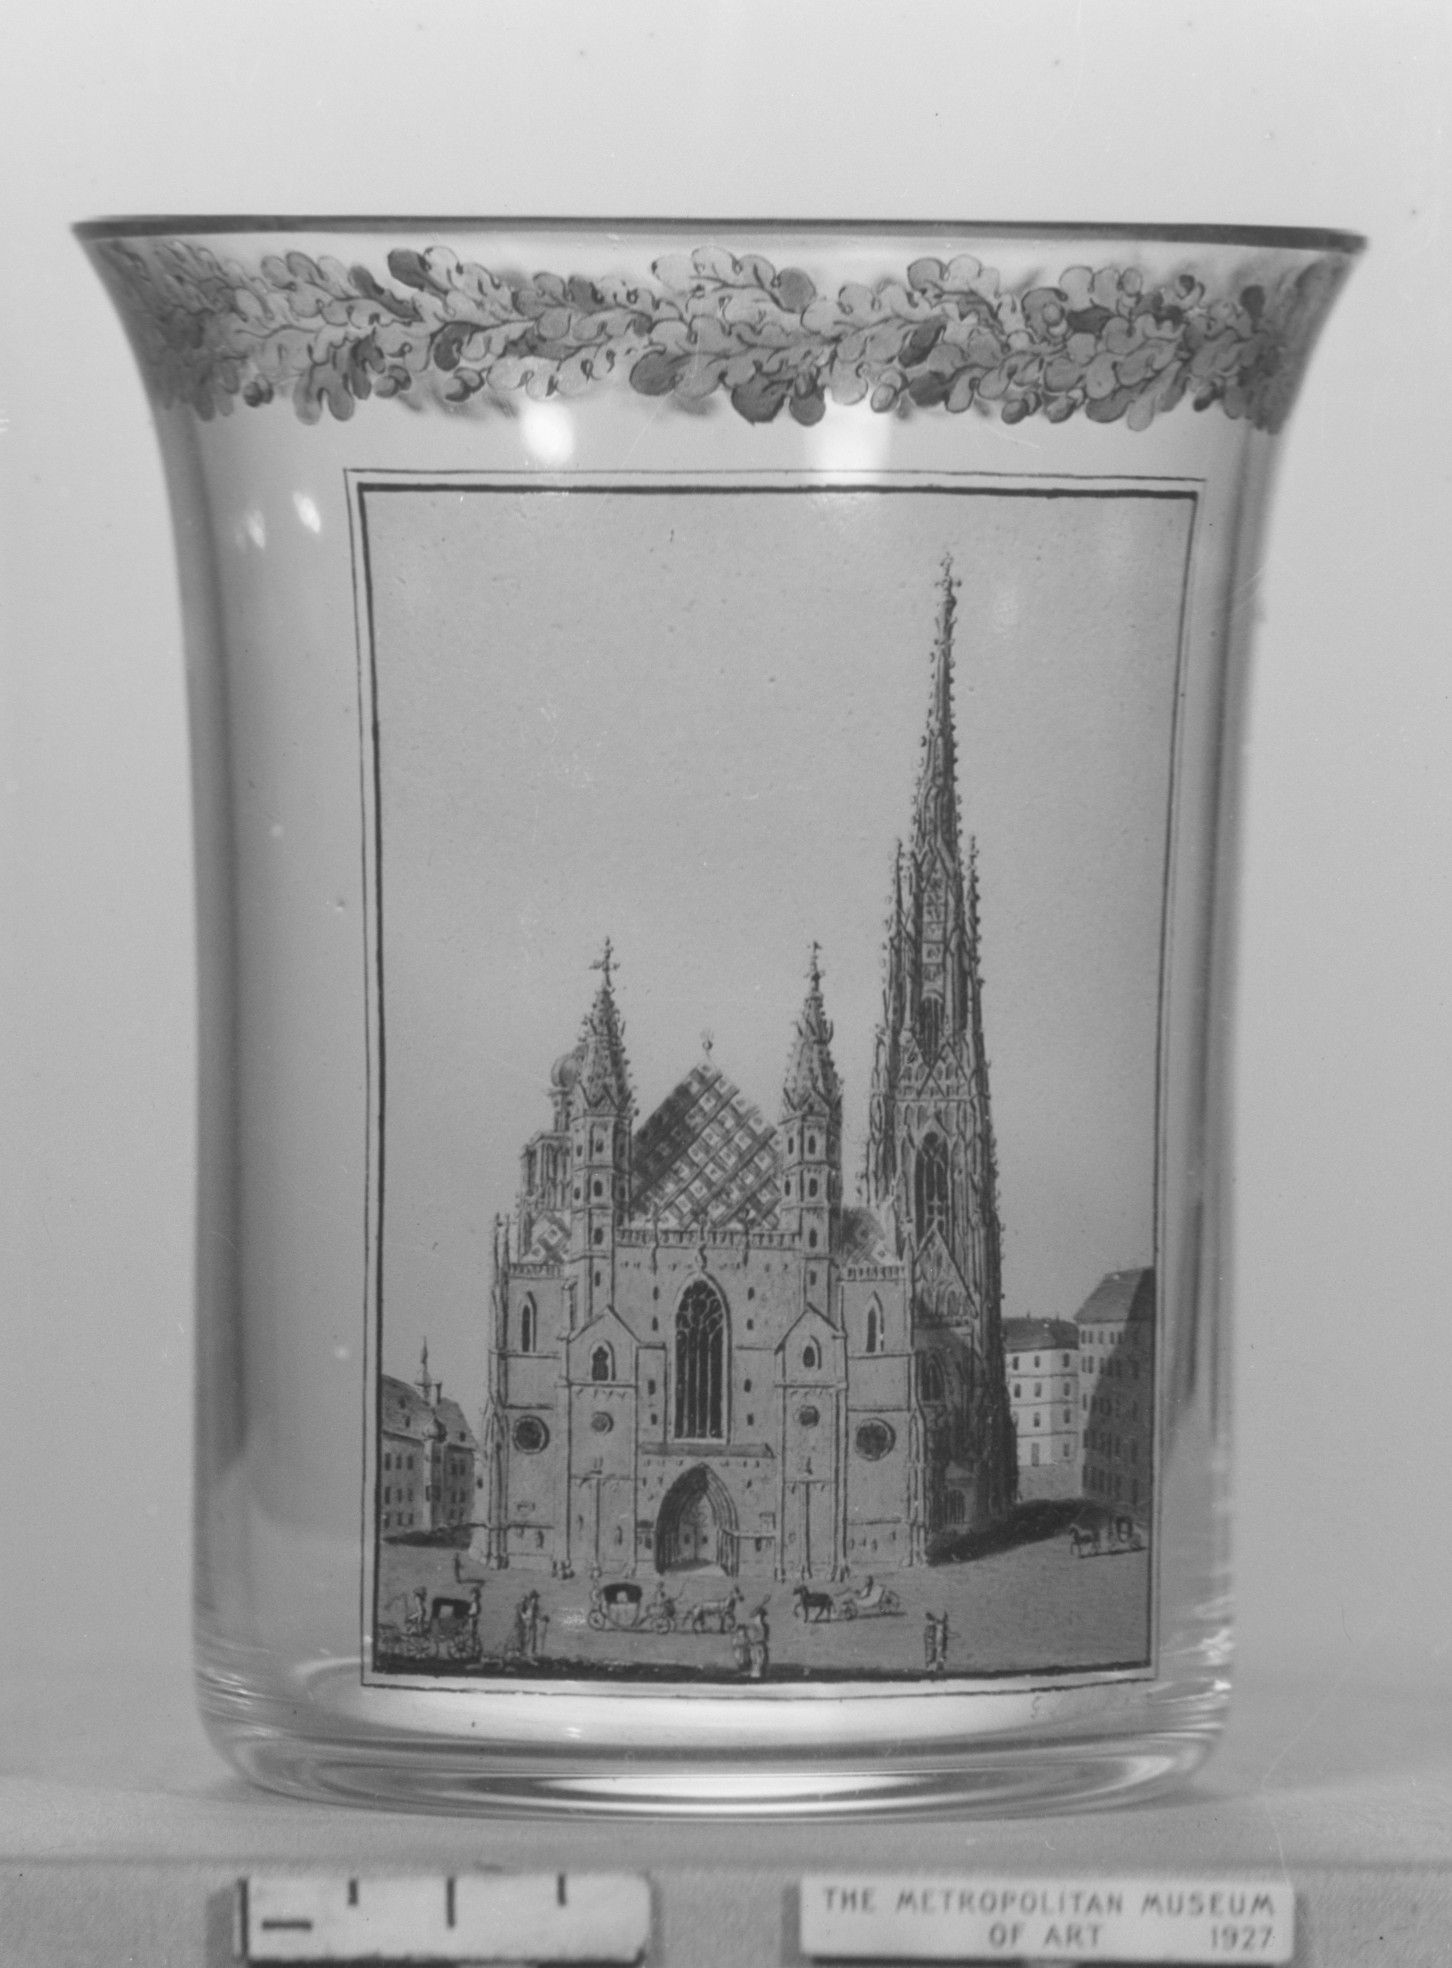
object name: beaker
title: Beaker with view of the Stephansdom, Vienna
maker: gottlob samuel mohn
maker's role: decorator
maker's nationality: austrian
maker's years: 1789-1825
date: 1812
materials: glass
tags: cathedrals